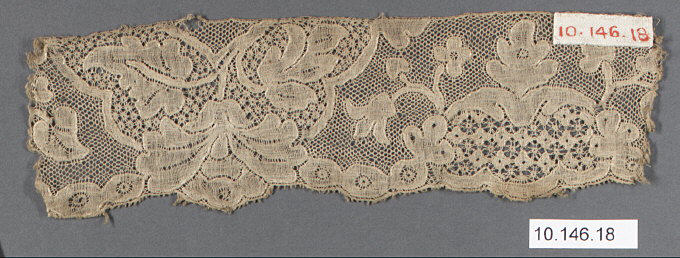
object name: fragment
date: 1701-1800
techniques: lace